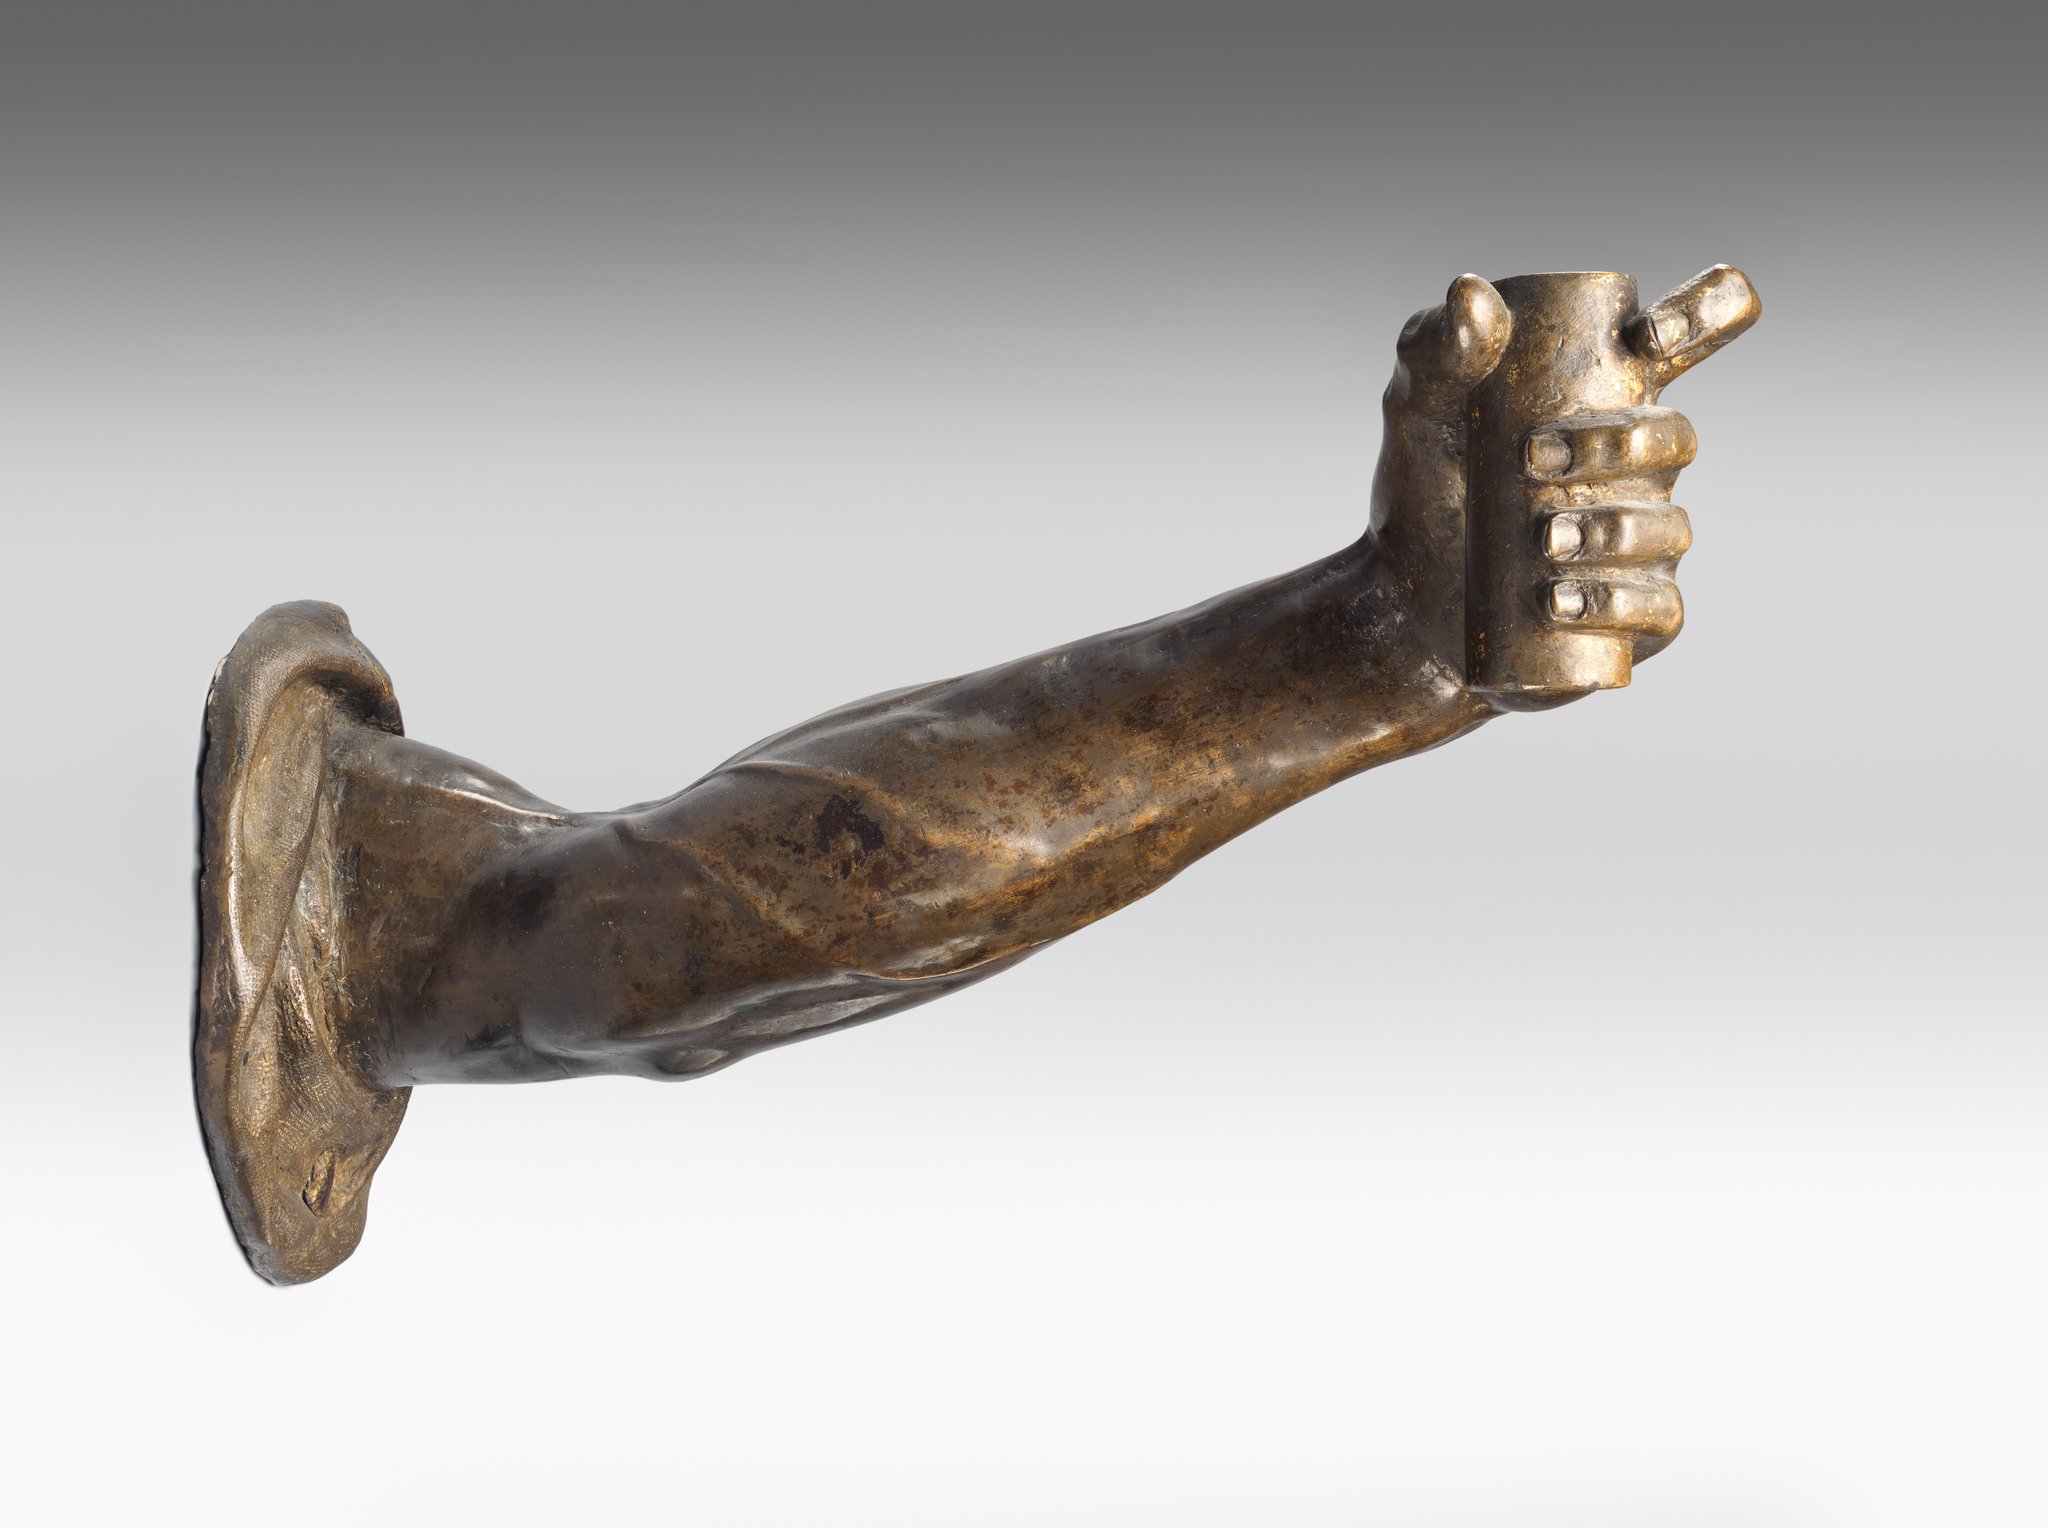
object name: sconce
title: Torch-bearing arm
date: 1567-1600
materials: bronze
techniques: gilding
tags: arms